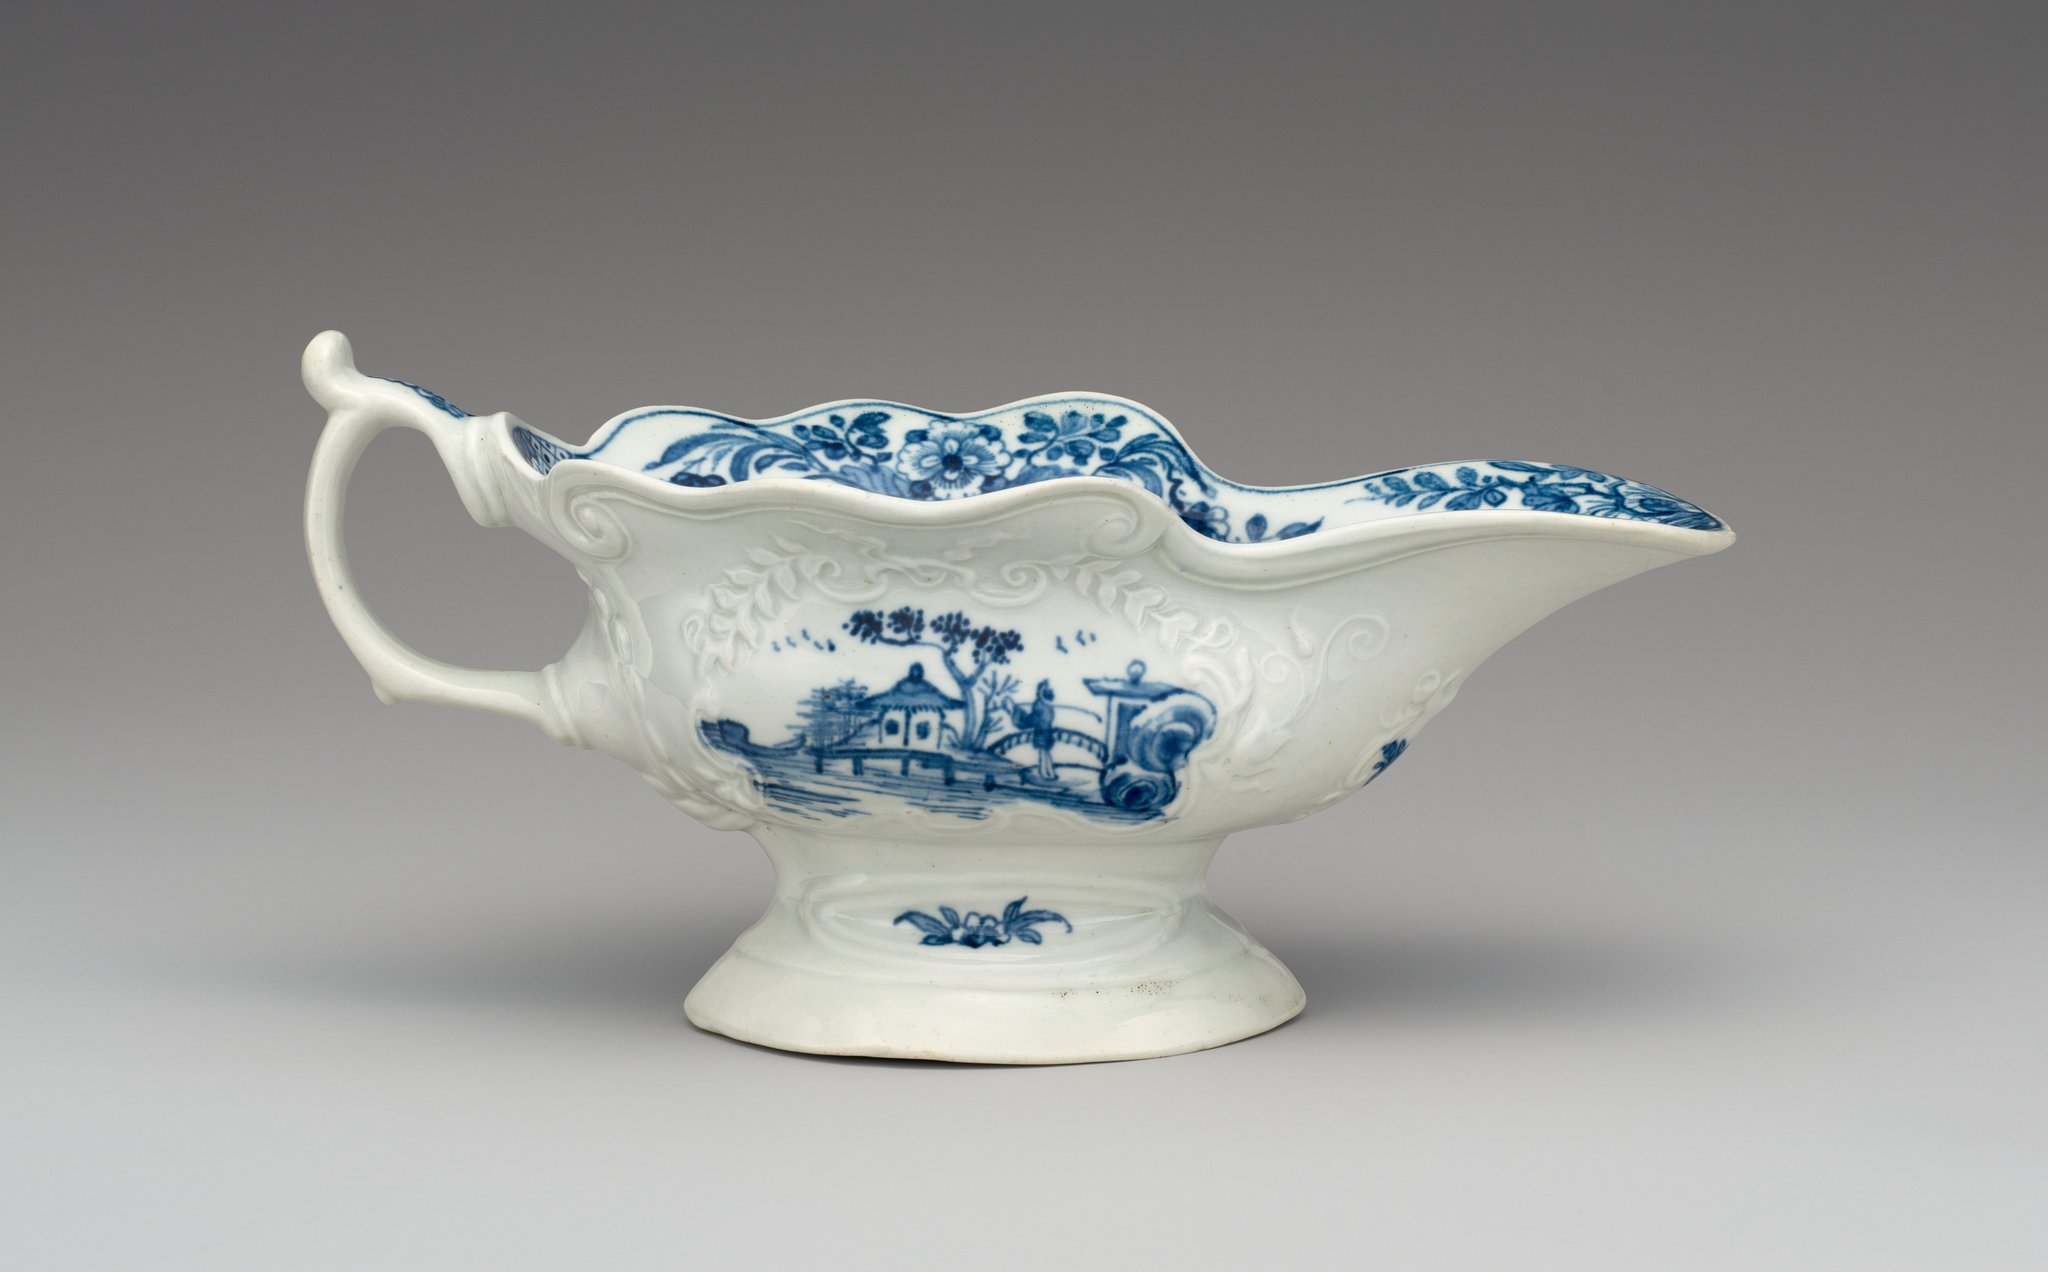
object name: sauceboat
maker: worcester factory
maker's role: factory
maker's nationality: british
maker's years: 1751-2008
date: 1760-1765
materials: soft paste porcelain